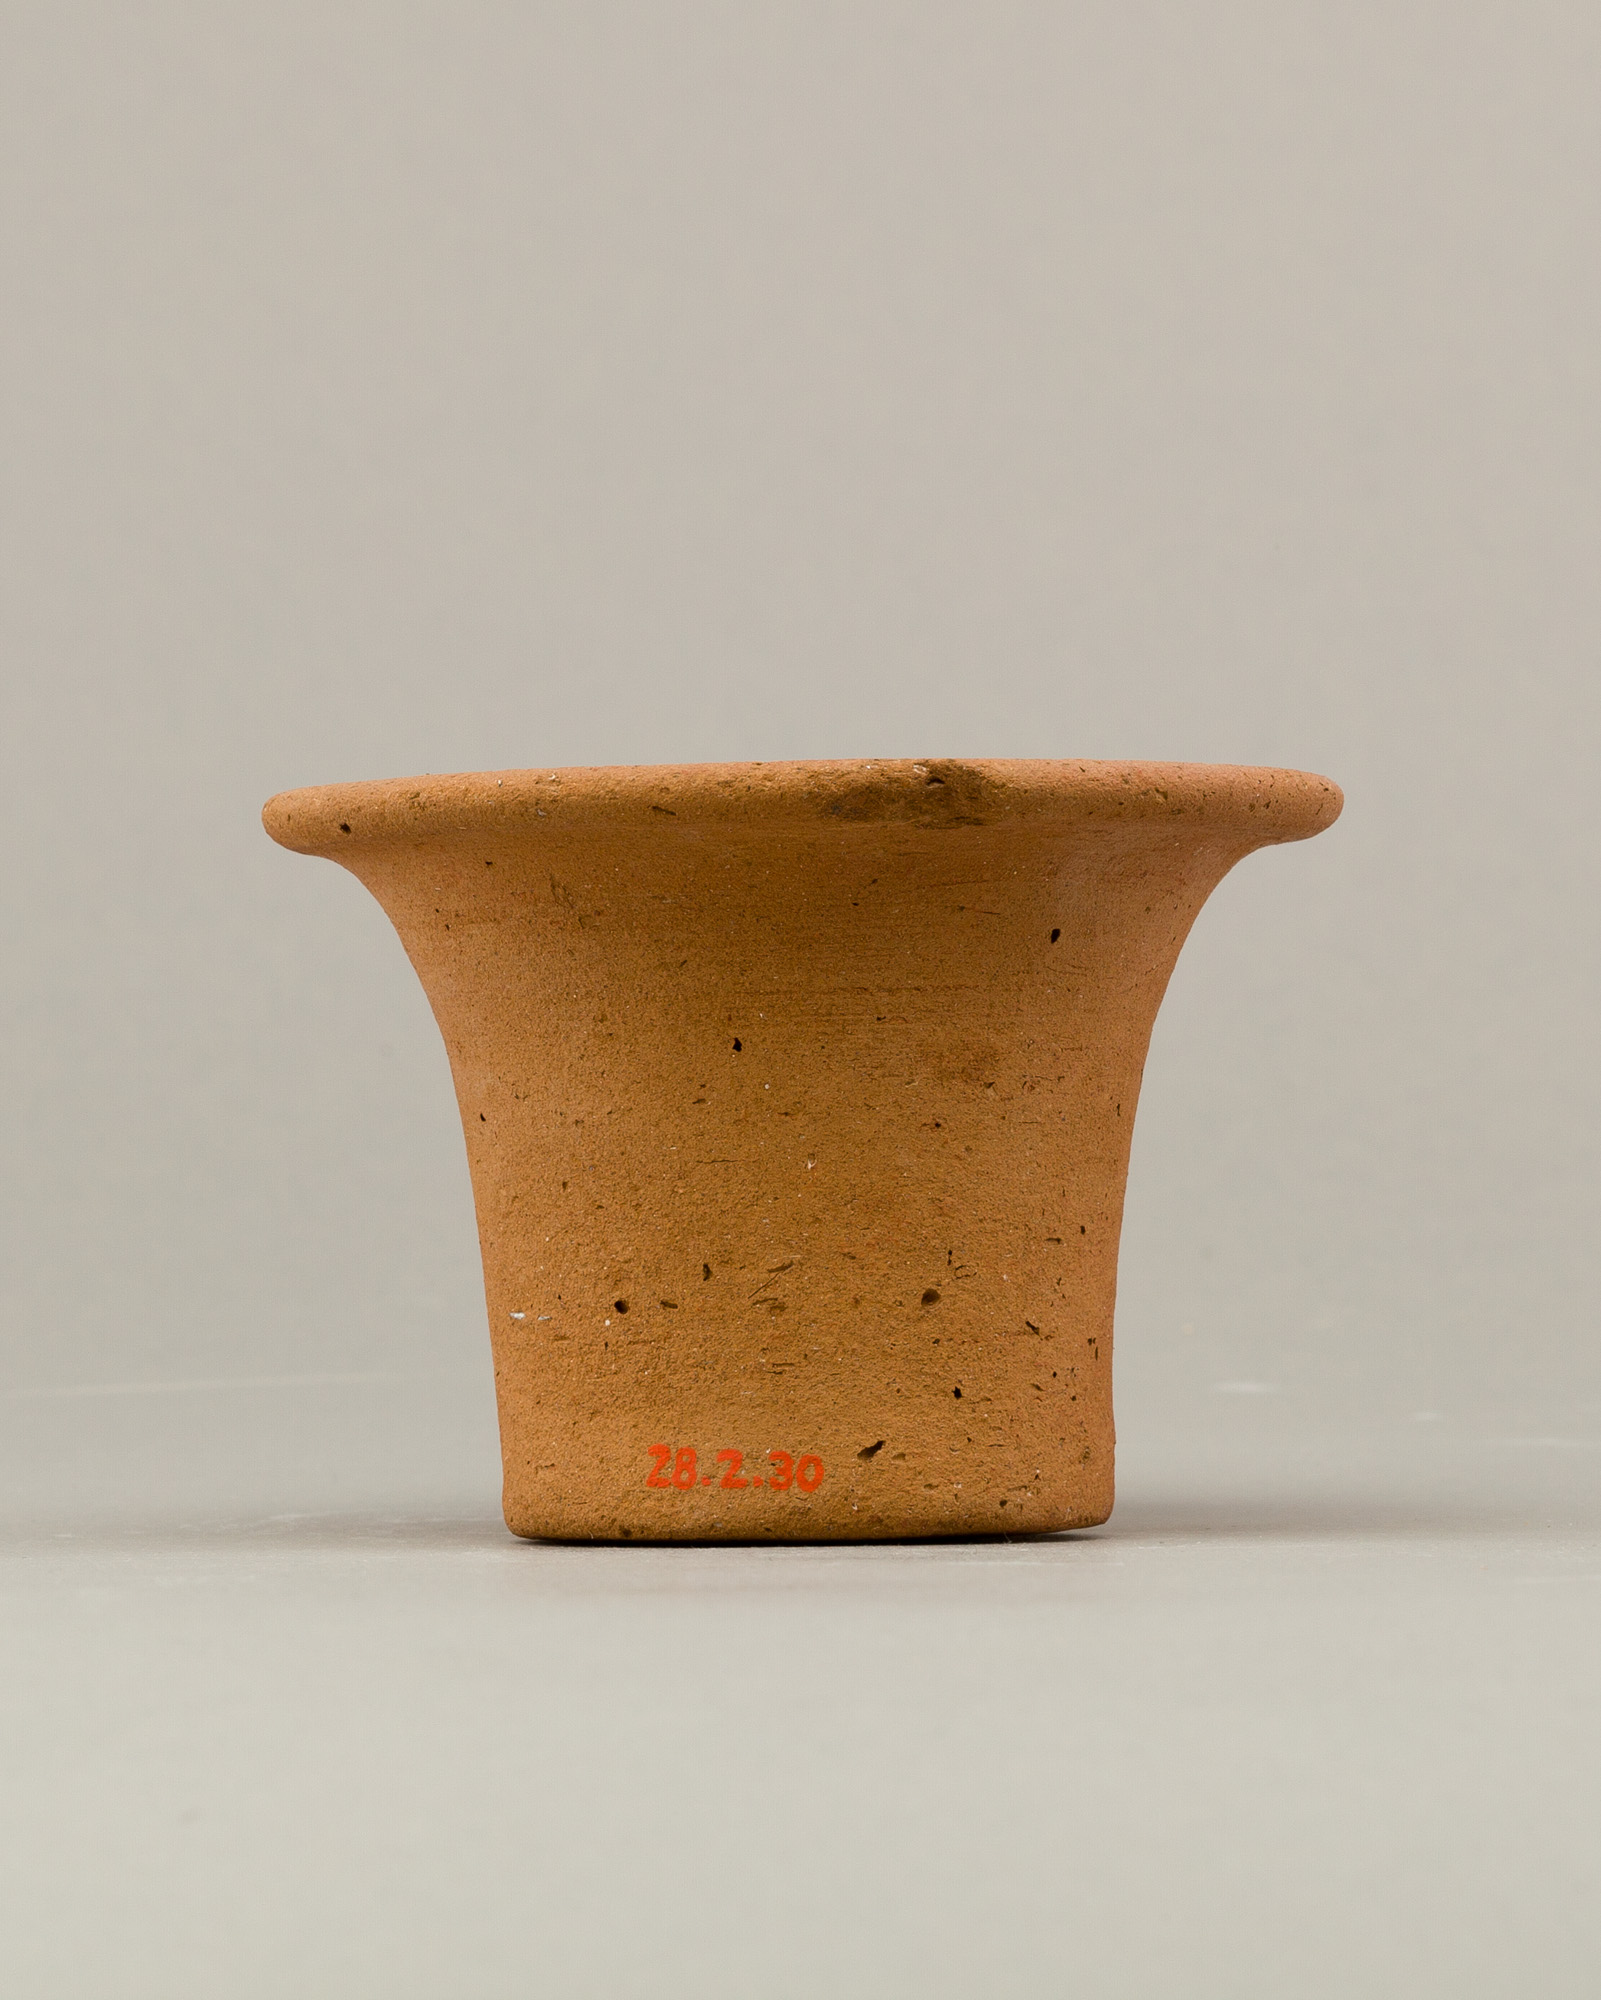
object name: cup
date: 2649-2100 BCE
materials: pottery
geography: egypt